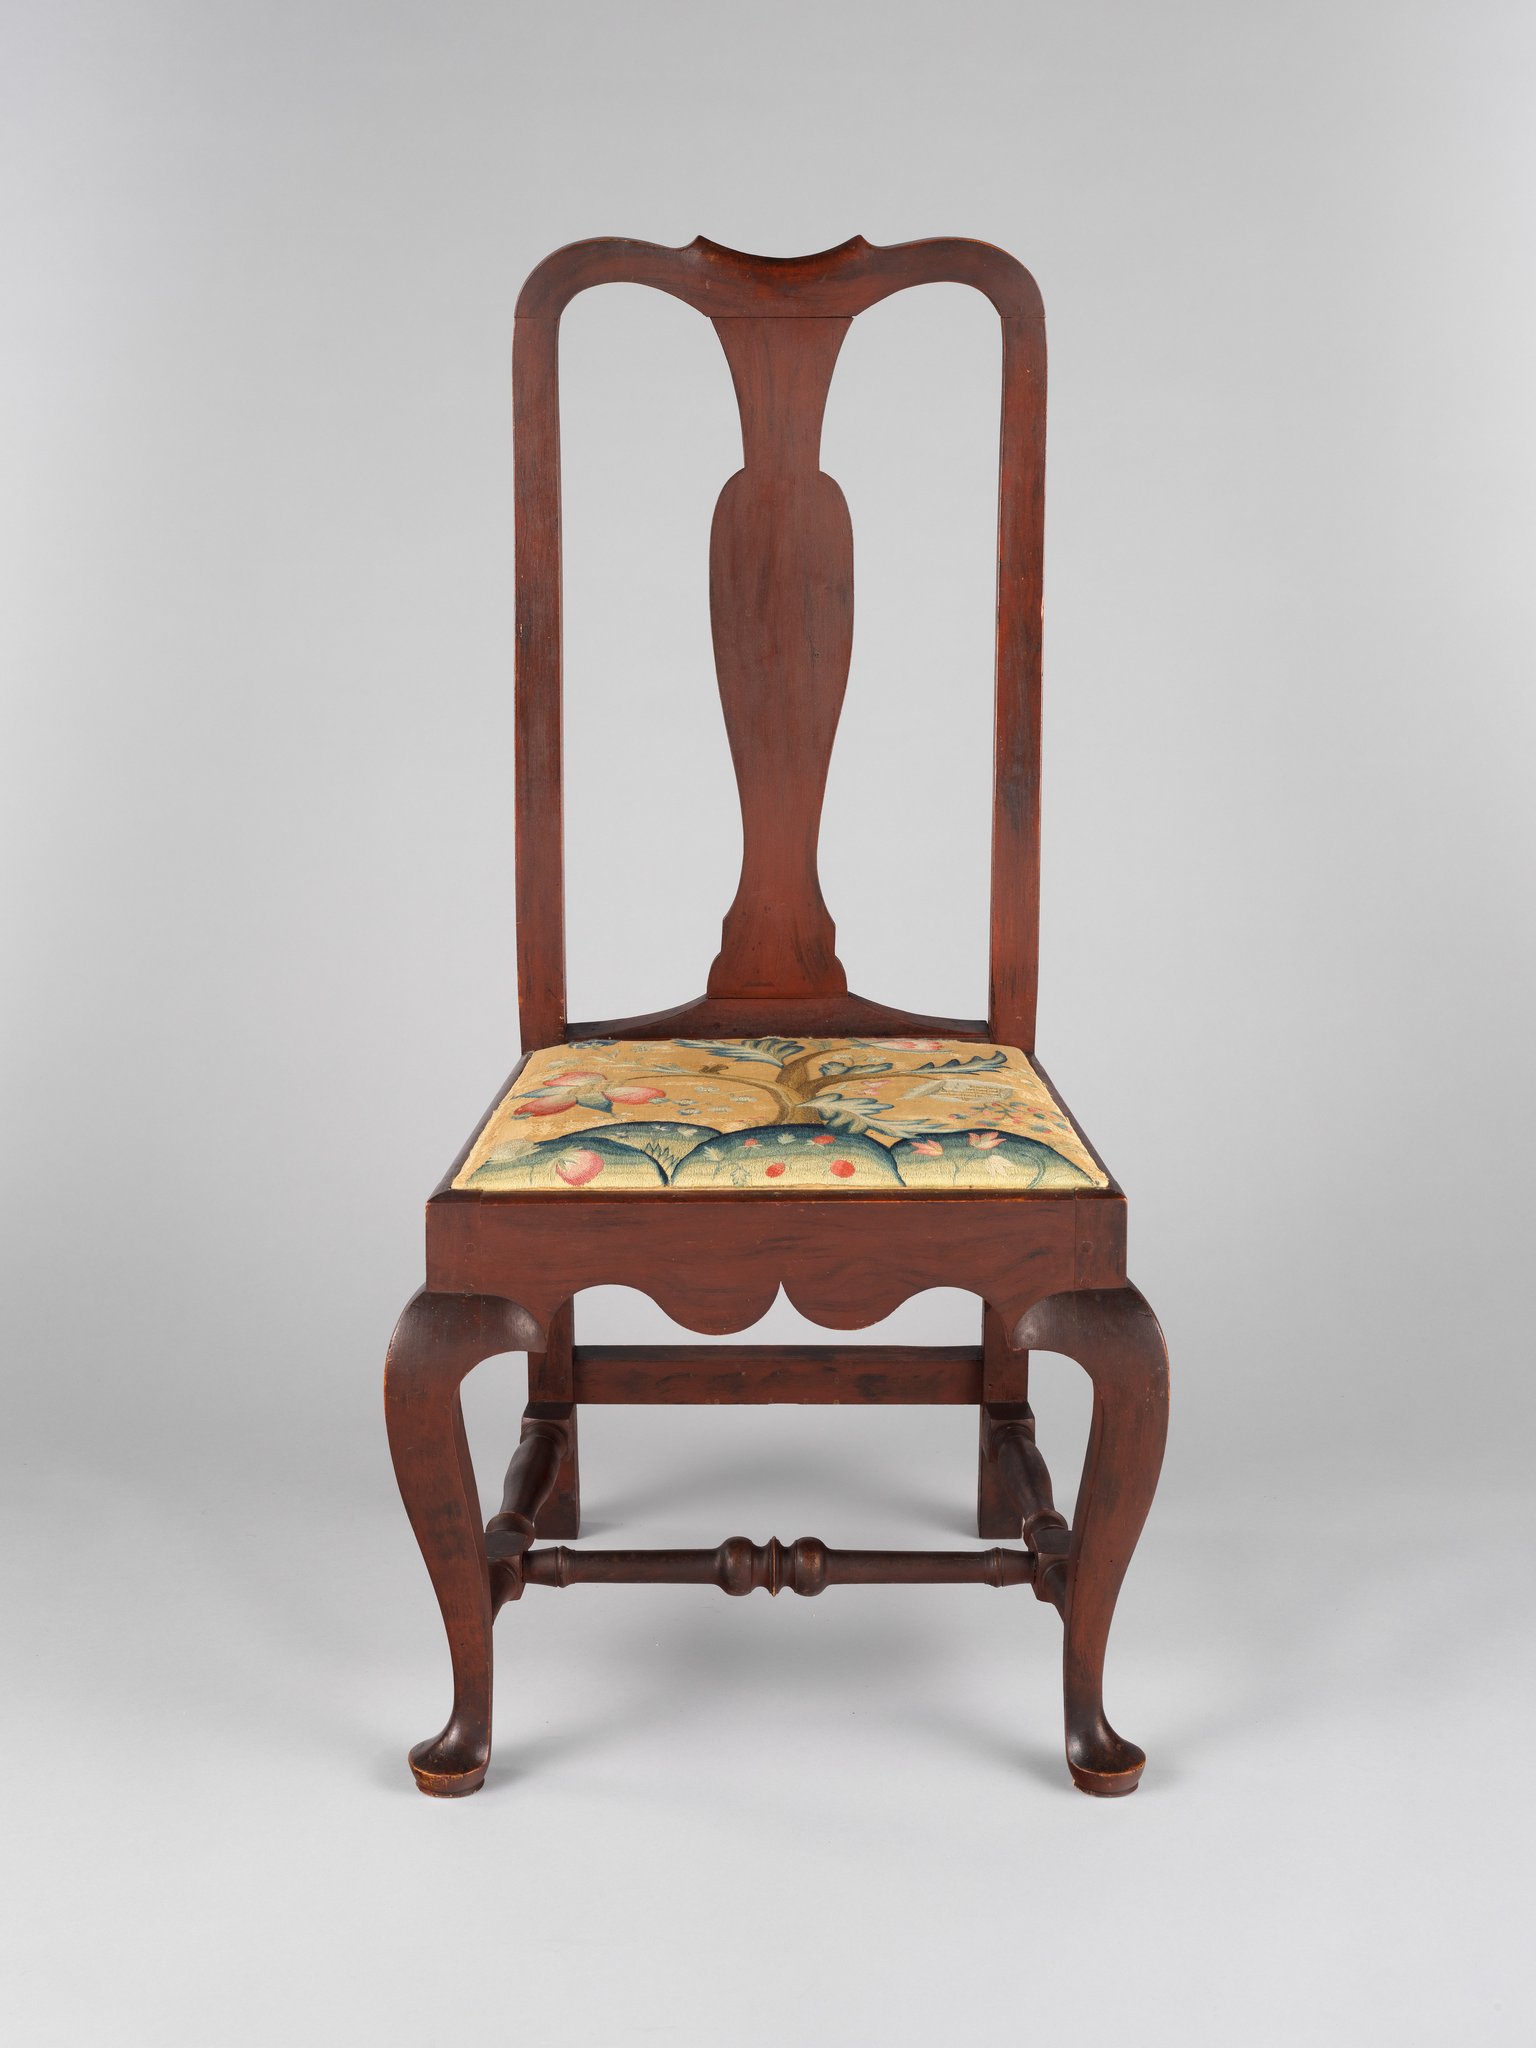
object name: side chair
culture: american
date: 1735-1760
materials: linen, wood, wool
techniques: painting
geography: united states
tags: birds,deer,lions